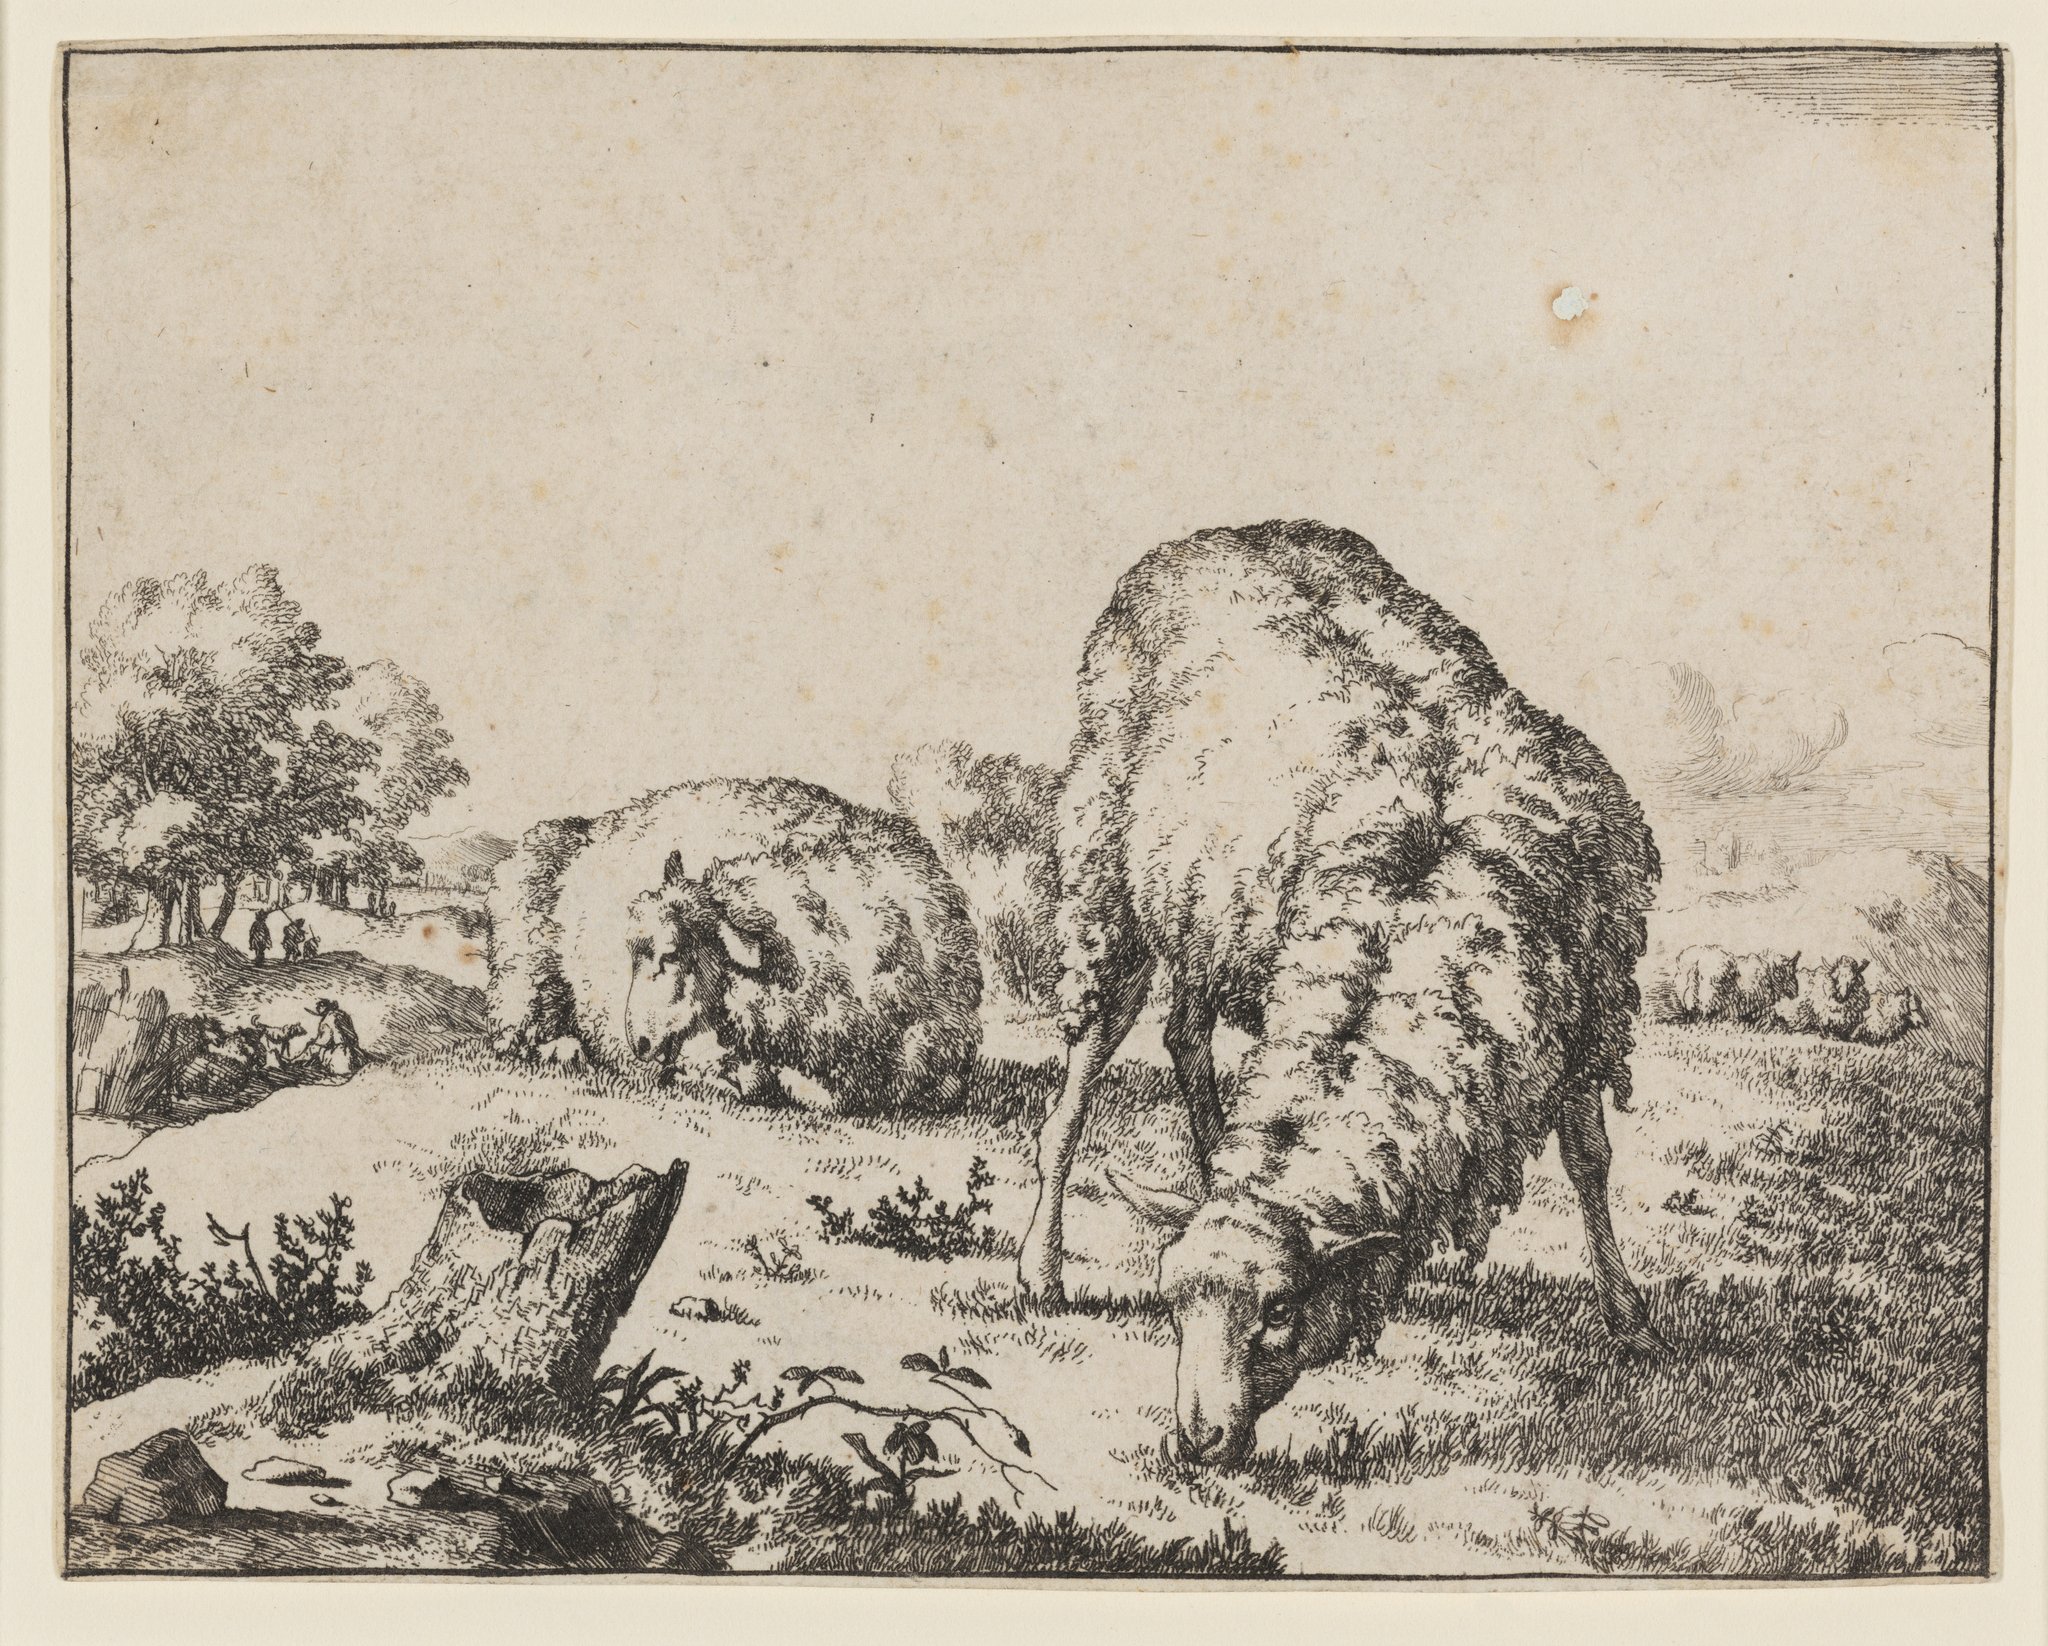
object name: print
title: Grazing Sheep, Seen from the Front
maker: marcus de bye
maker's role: artist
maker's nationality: dutch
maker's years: 1639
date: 1664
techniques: etching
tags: sheep